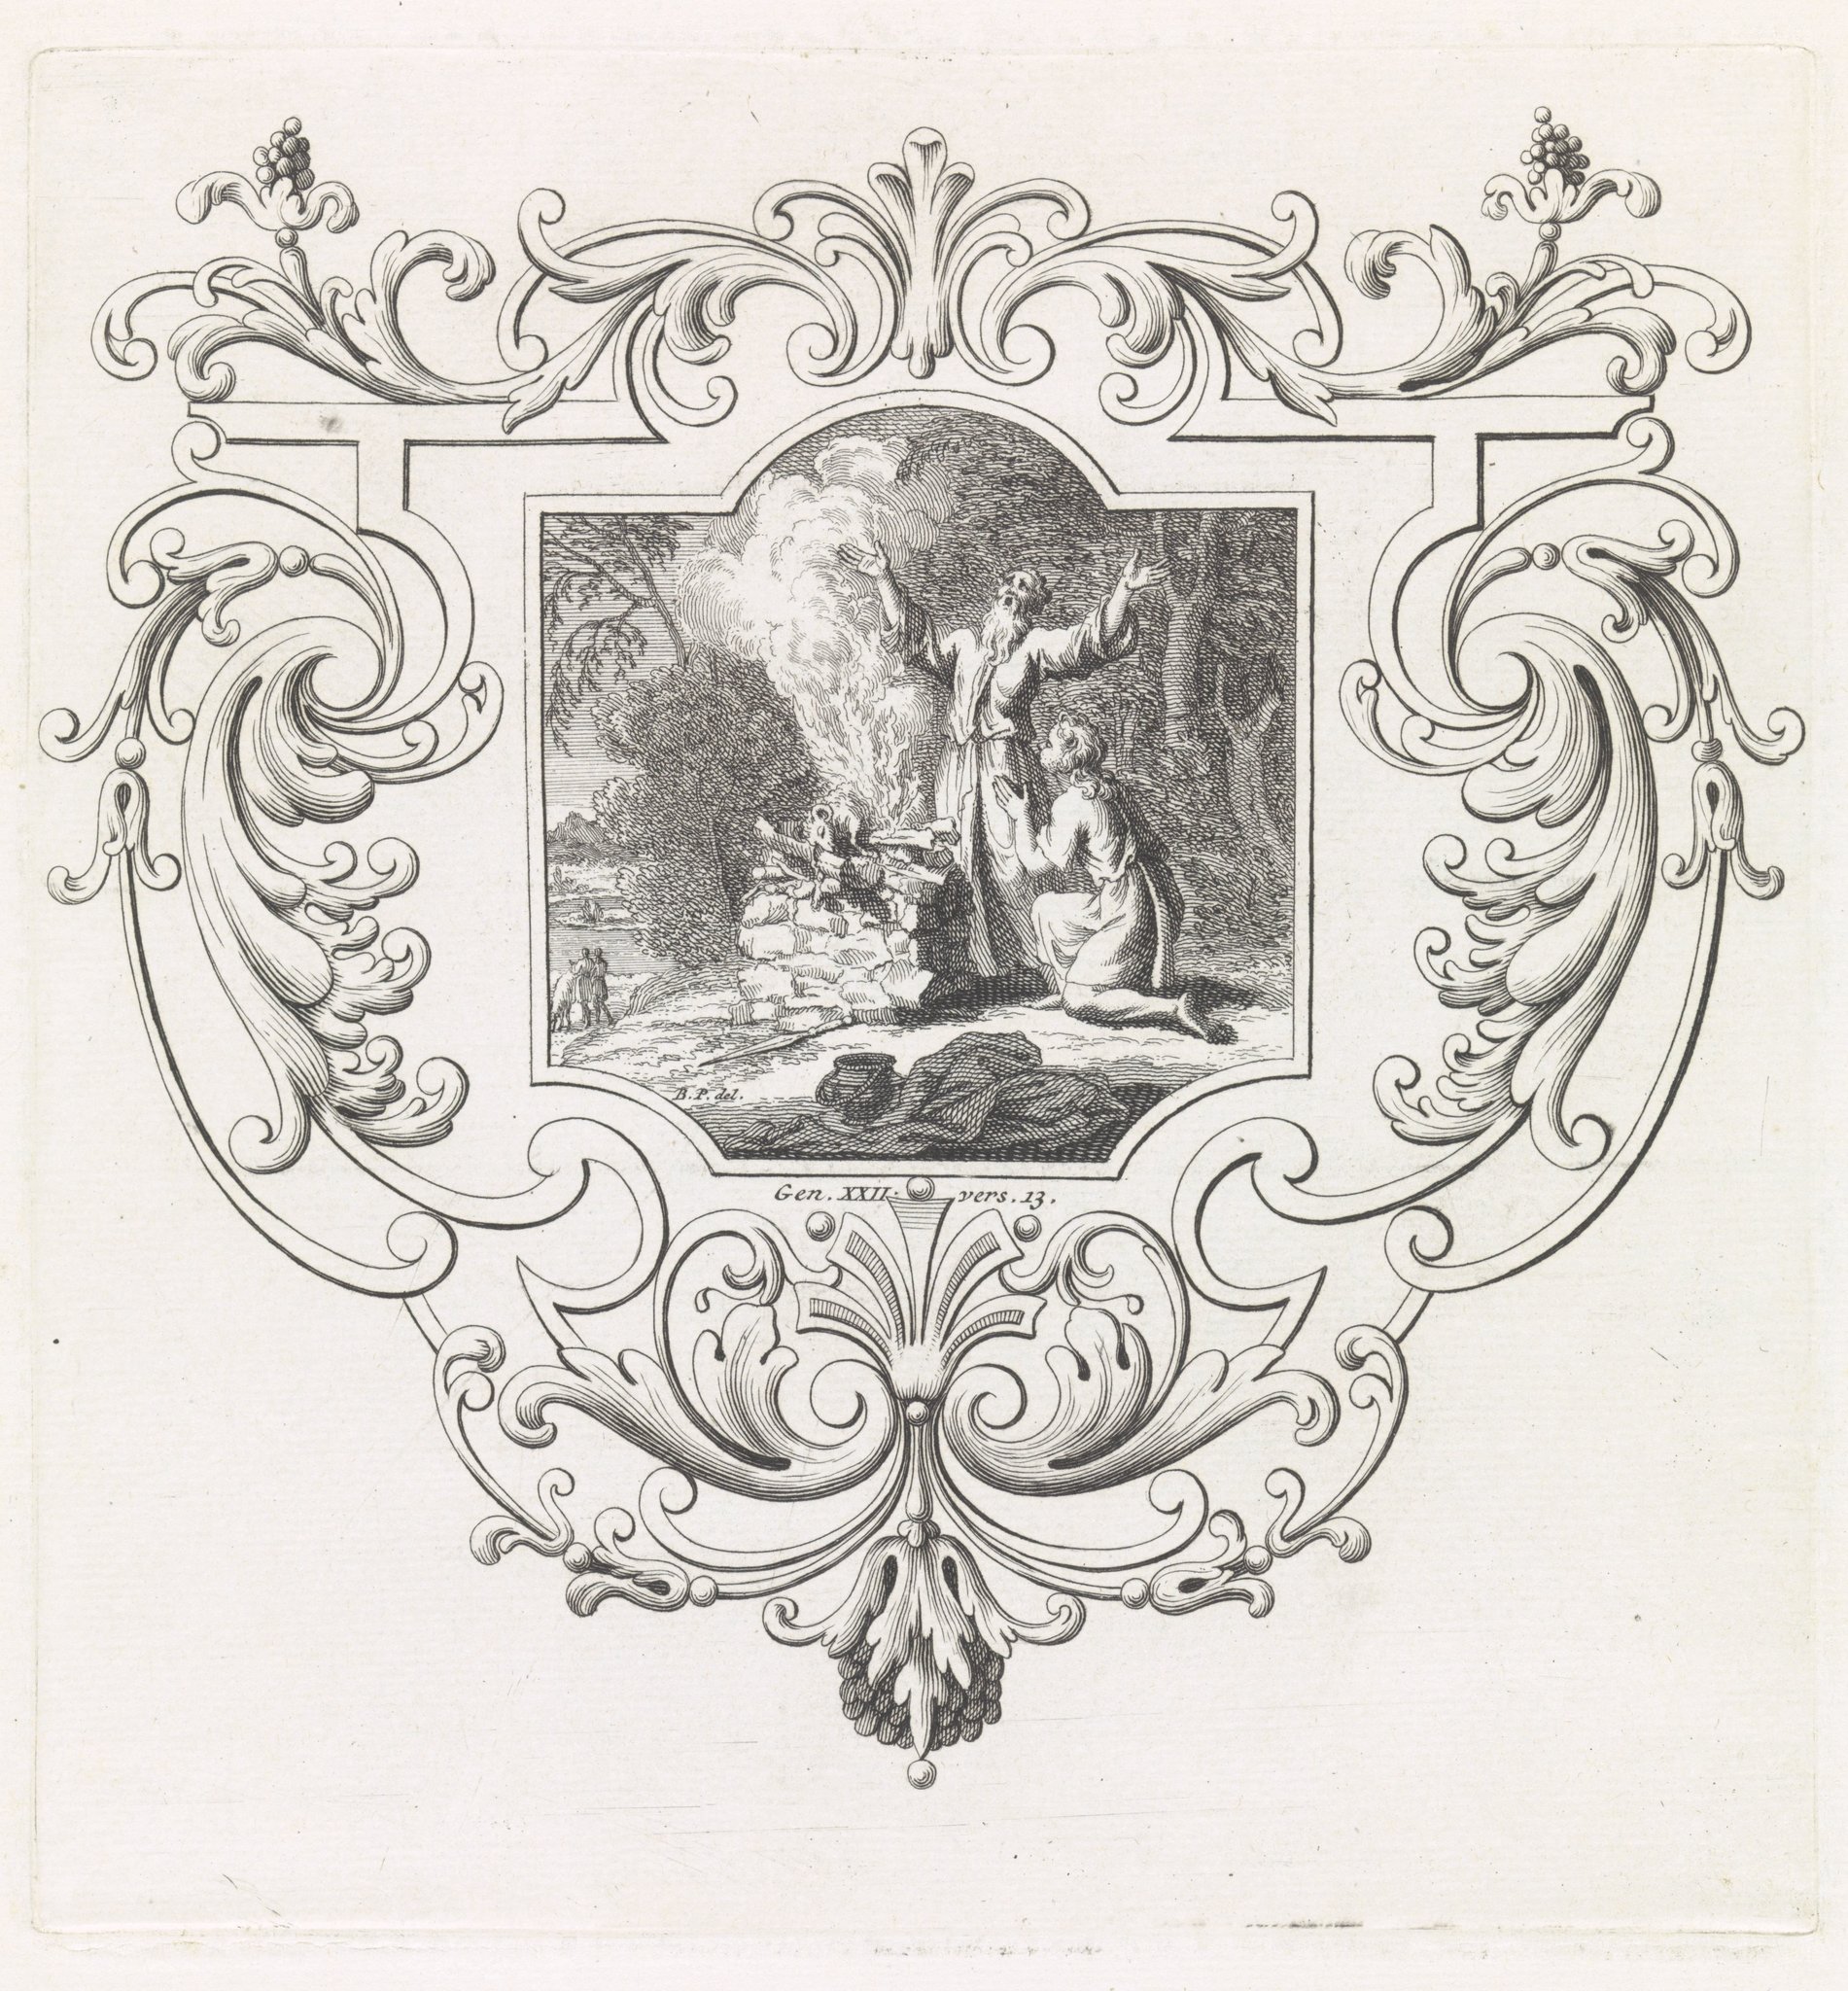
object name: ornament print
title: Abraham en Isaak offeren de ram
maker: bernard picart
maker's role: draughtsman, print maker, publisher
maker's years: 1673-1733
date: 1683-1733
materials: paper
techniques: engraving, etching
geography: amsterdam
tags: a ram caught in a thicket is sacrificed instead of isaac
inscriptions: collector's mark: Lugt 2233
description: Prent oorspronkelijk bedoeld voor: Figures de la Bible. Amsterdam, Bernard Picart, 1720. Prent ook gebruikt in: Taferelen der voornaamste geschiedenissen van het Oude en Nieuwe Testament (...) door de vermaarde kunstenaars Hoet, Houbraken, en Picart getekent (...) en met beschrijvingen uitgebreid. Den Haag: Pieter de Hondt, 1728. Prent kan mogelijk ook zijn gebruikt in andere bijbels.